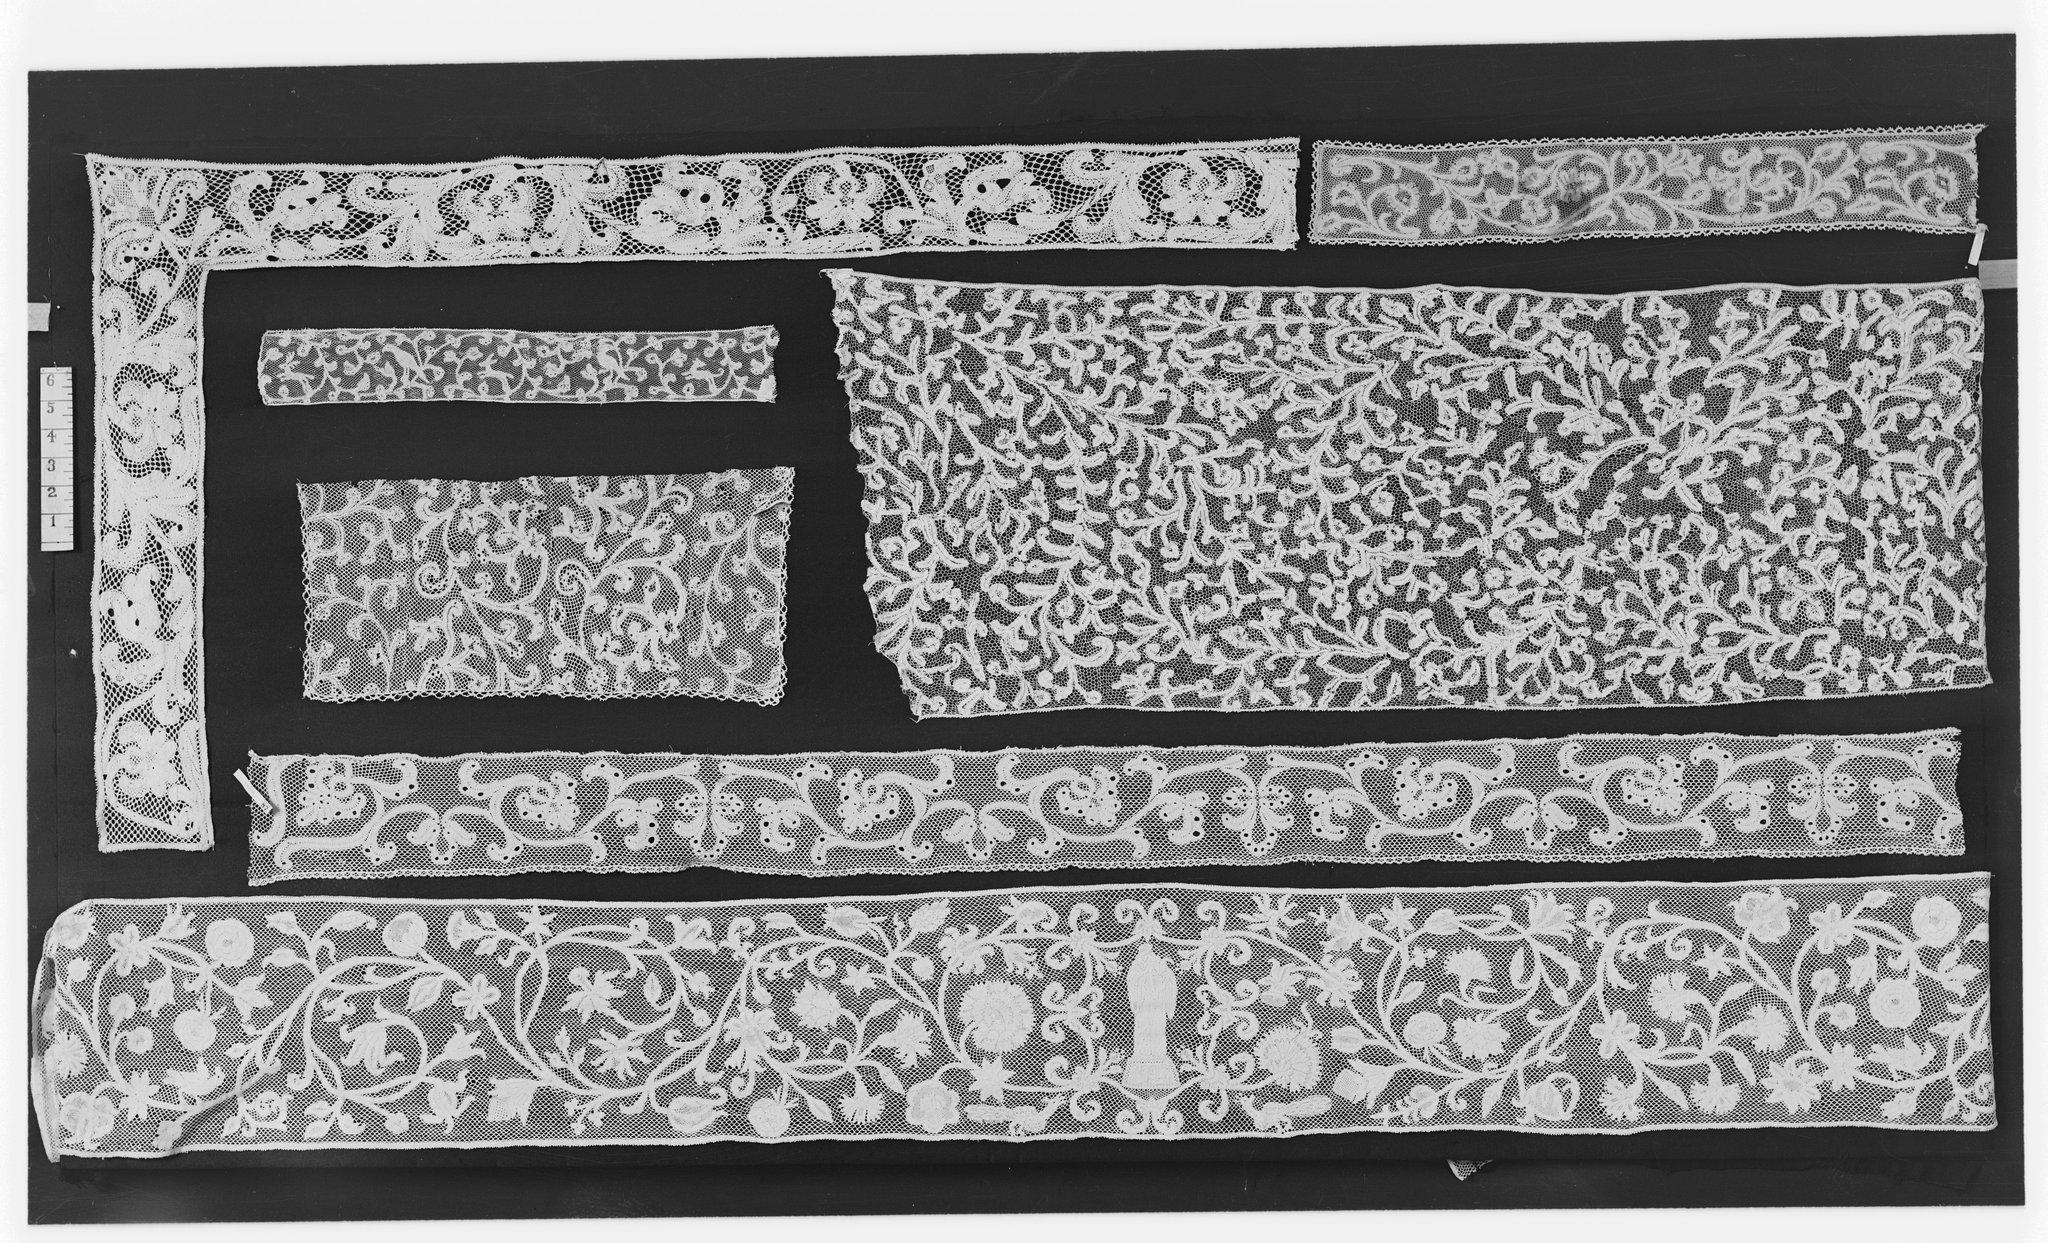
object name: fragment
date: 1701-1800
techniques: lace